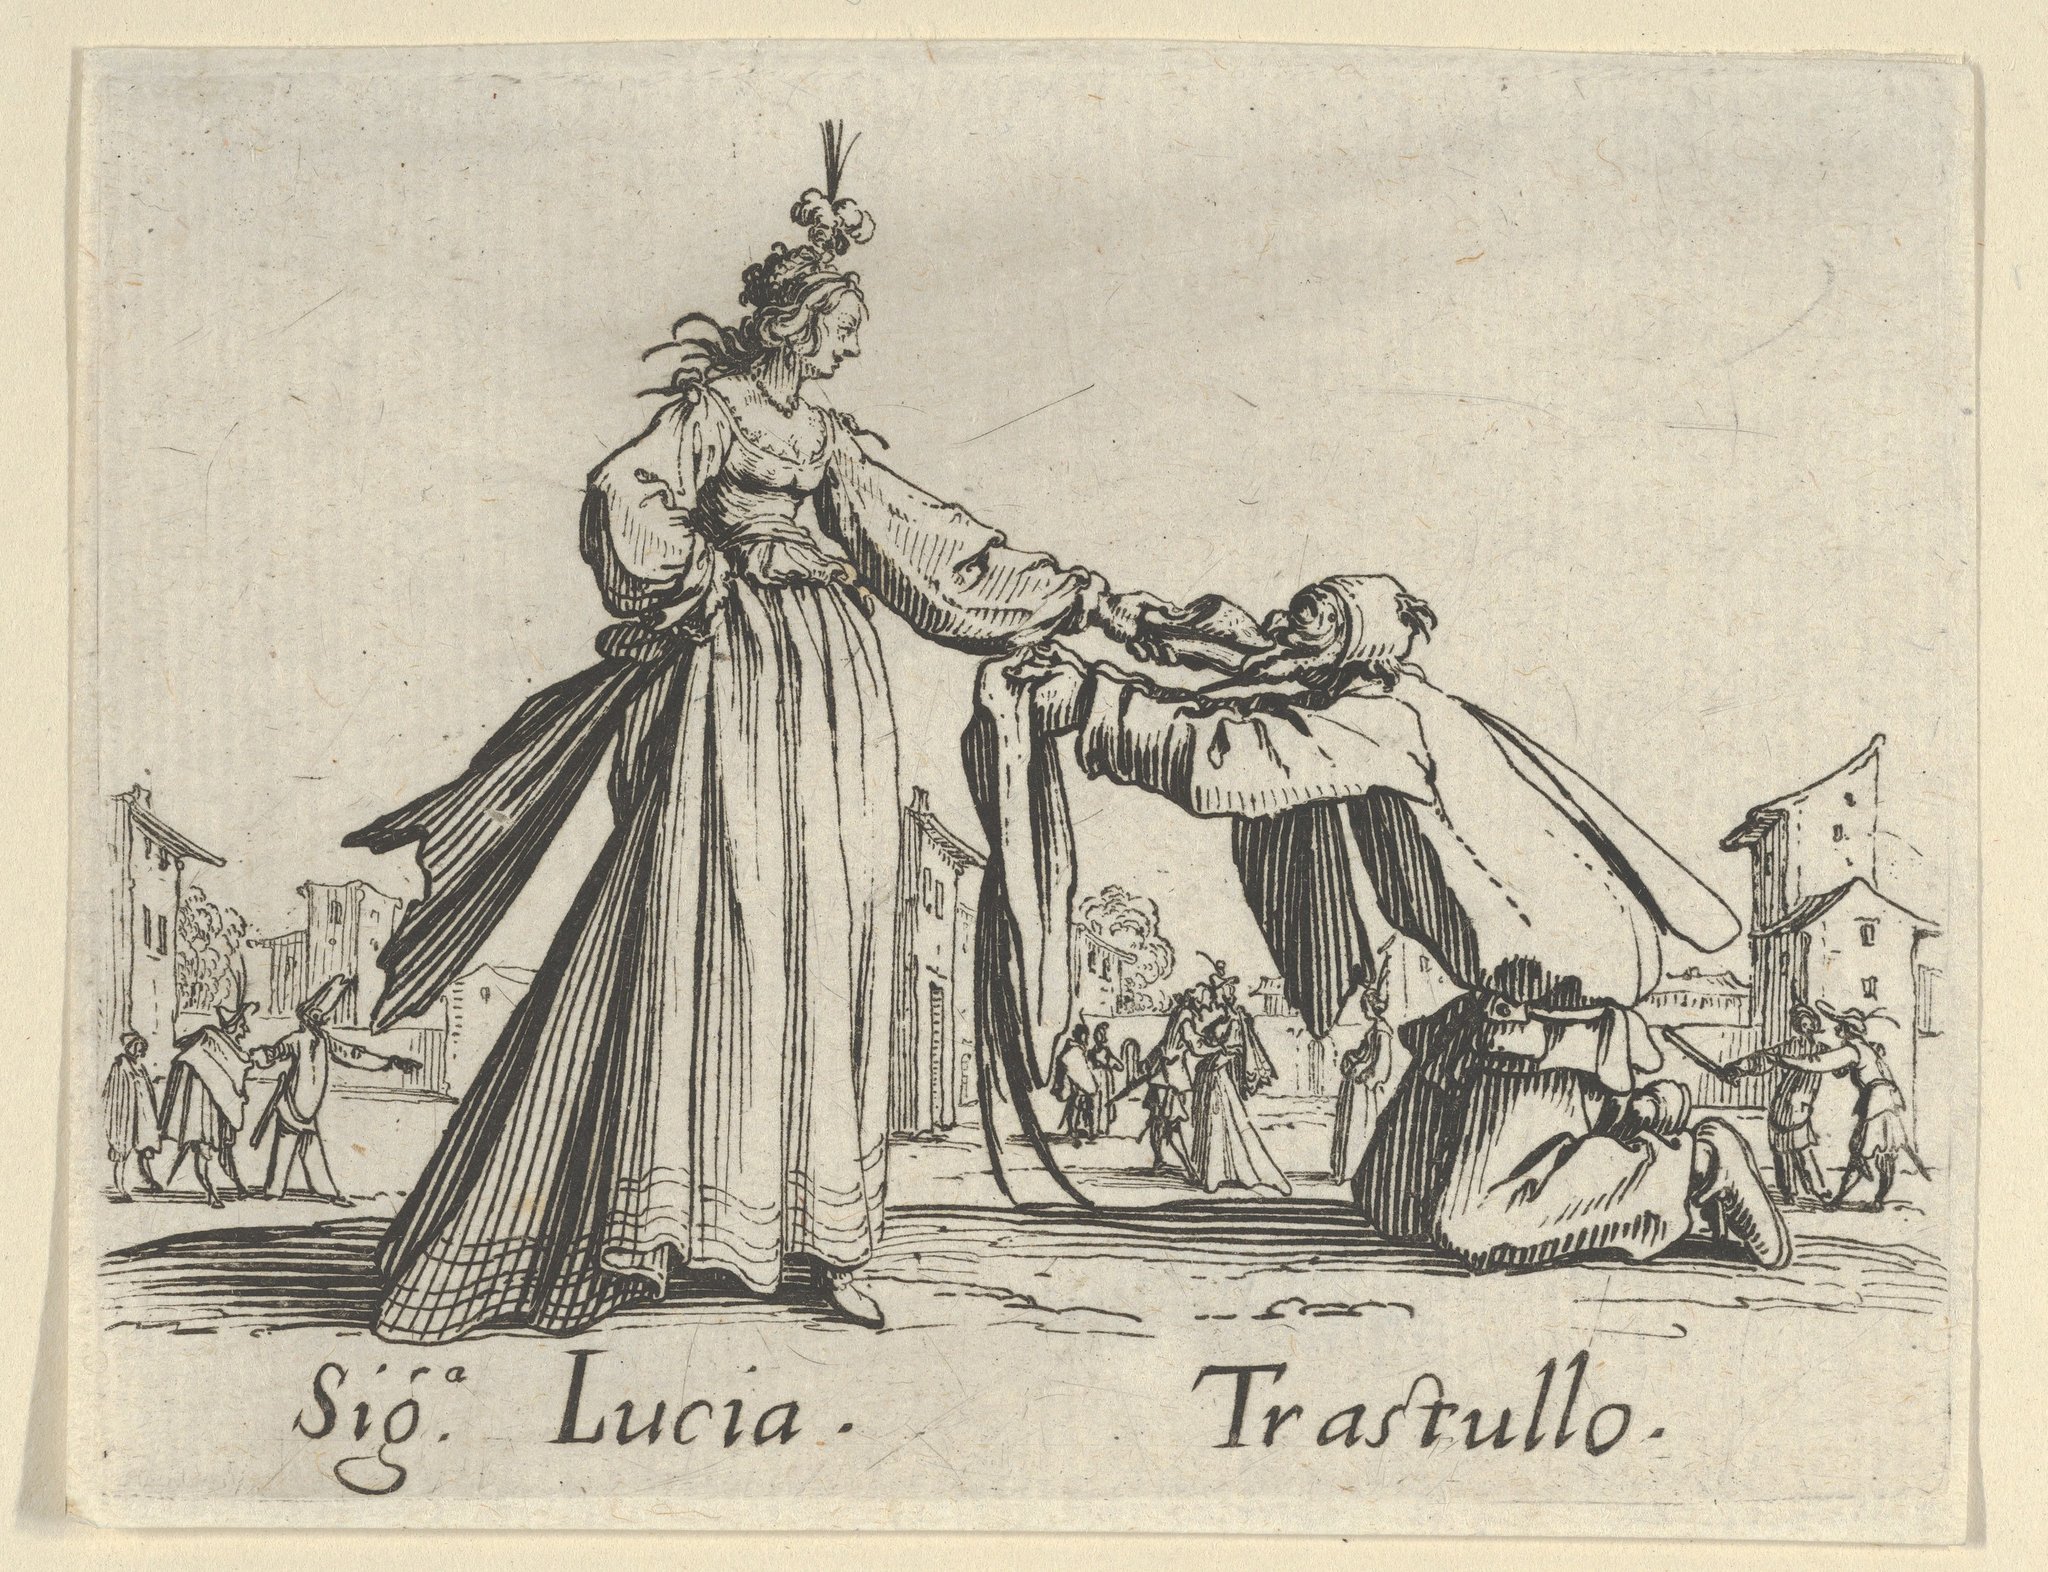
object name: print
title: Sig. Lucia - Trastullo, from "Balli di Sfessania" (Dance of Sfessania)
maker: jacques callot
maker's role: artist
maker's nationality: french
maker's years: 1592-1635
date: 1622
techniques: etching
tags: men,women